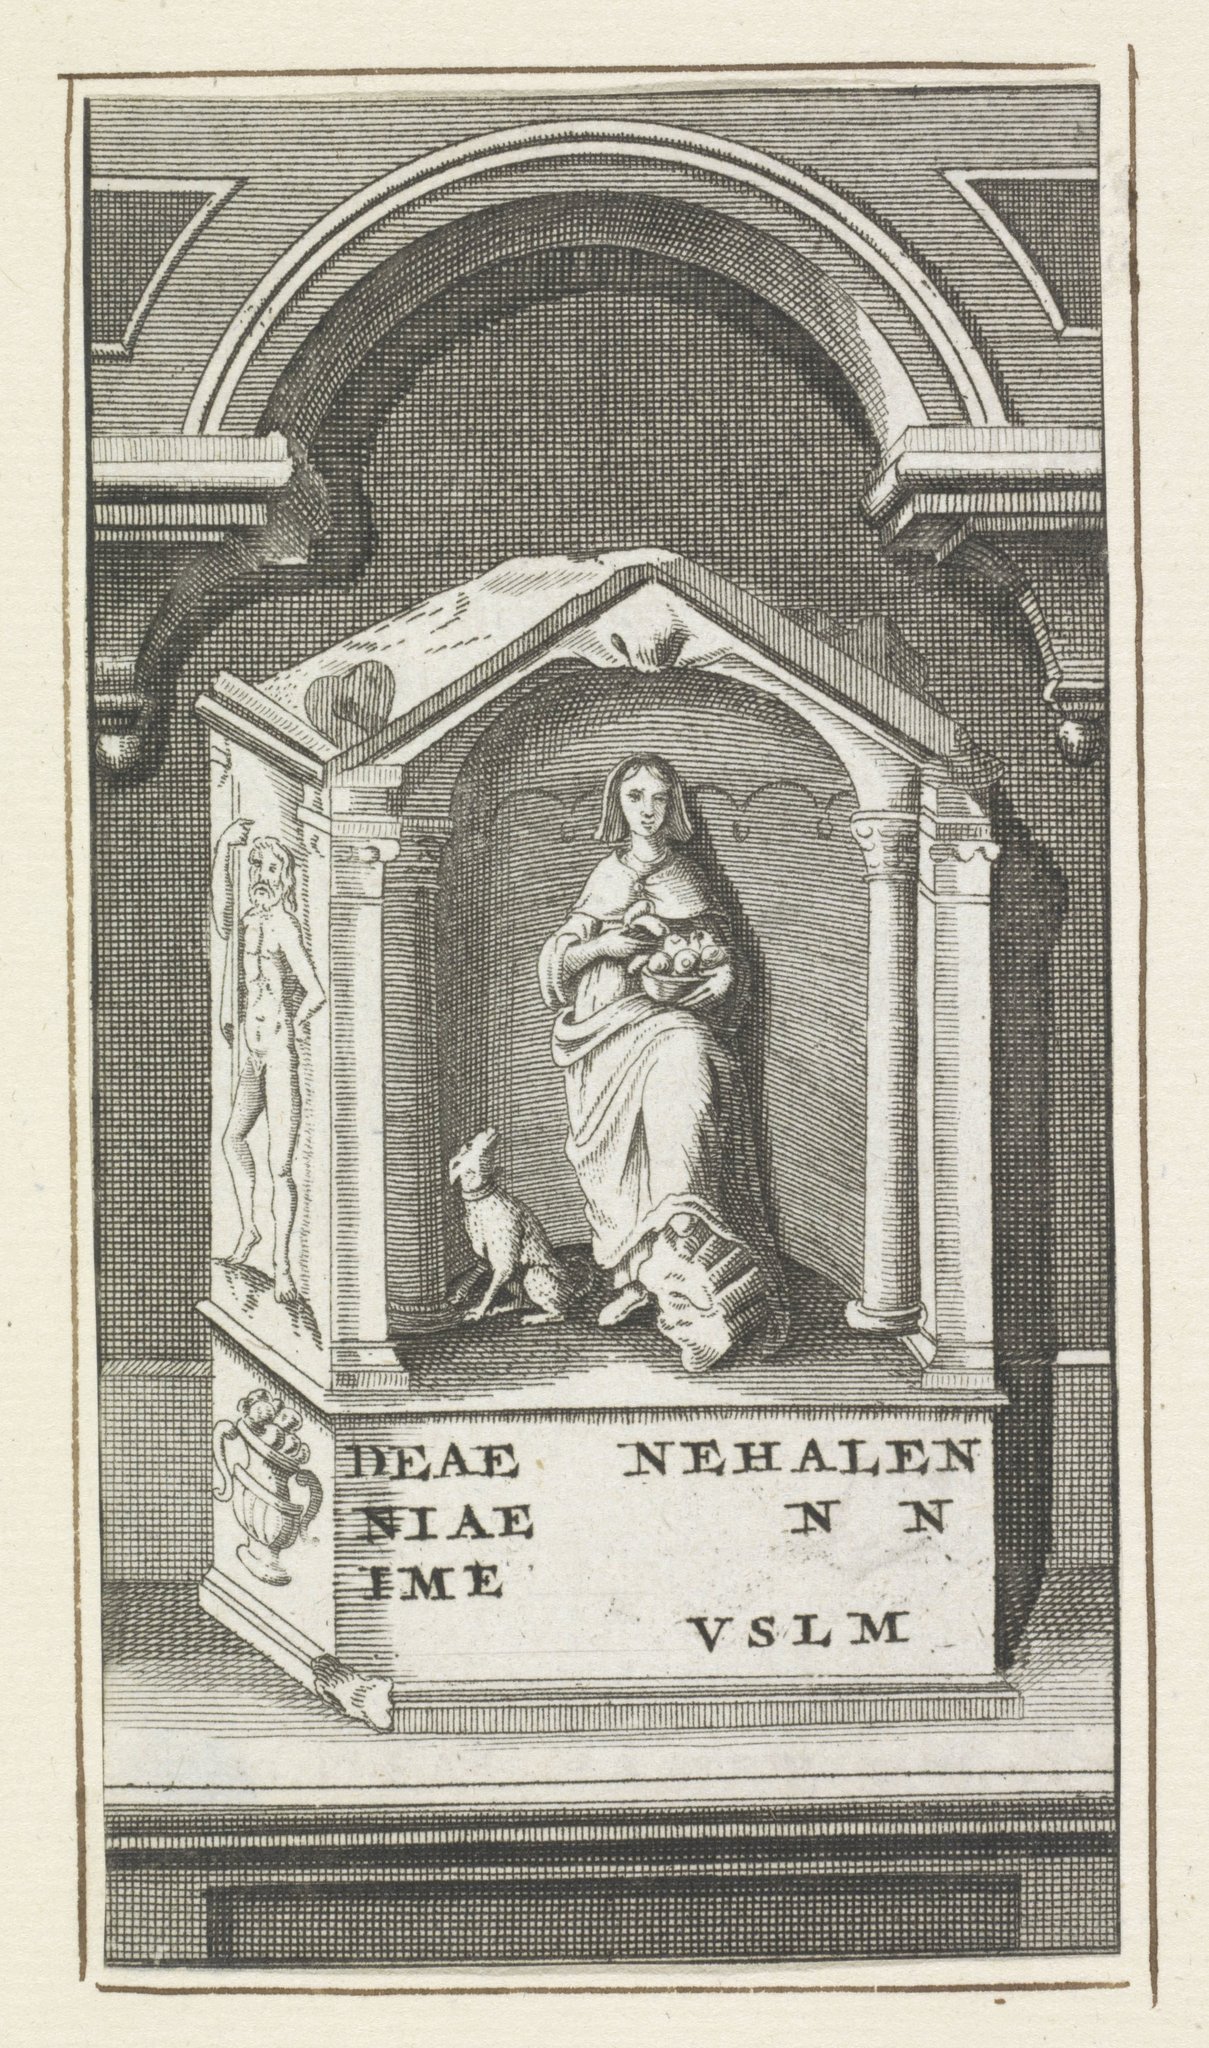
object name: book illustration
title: Nehalennia-altaar met staande Nehalennia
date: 1715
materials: paper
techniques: etching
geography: leiden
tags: other foreign deities included in the classical pantheon (with name)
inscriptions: collector's mark: Lugt 2228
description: Een Nehalennia-altaar dat is gevonden bij Domburg op Walcheren. De godin Nehallenia staande met een mand vruchten in haar hand. naast haar een hond.